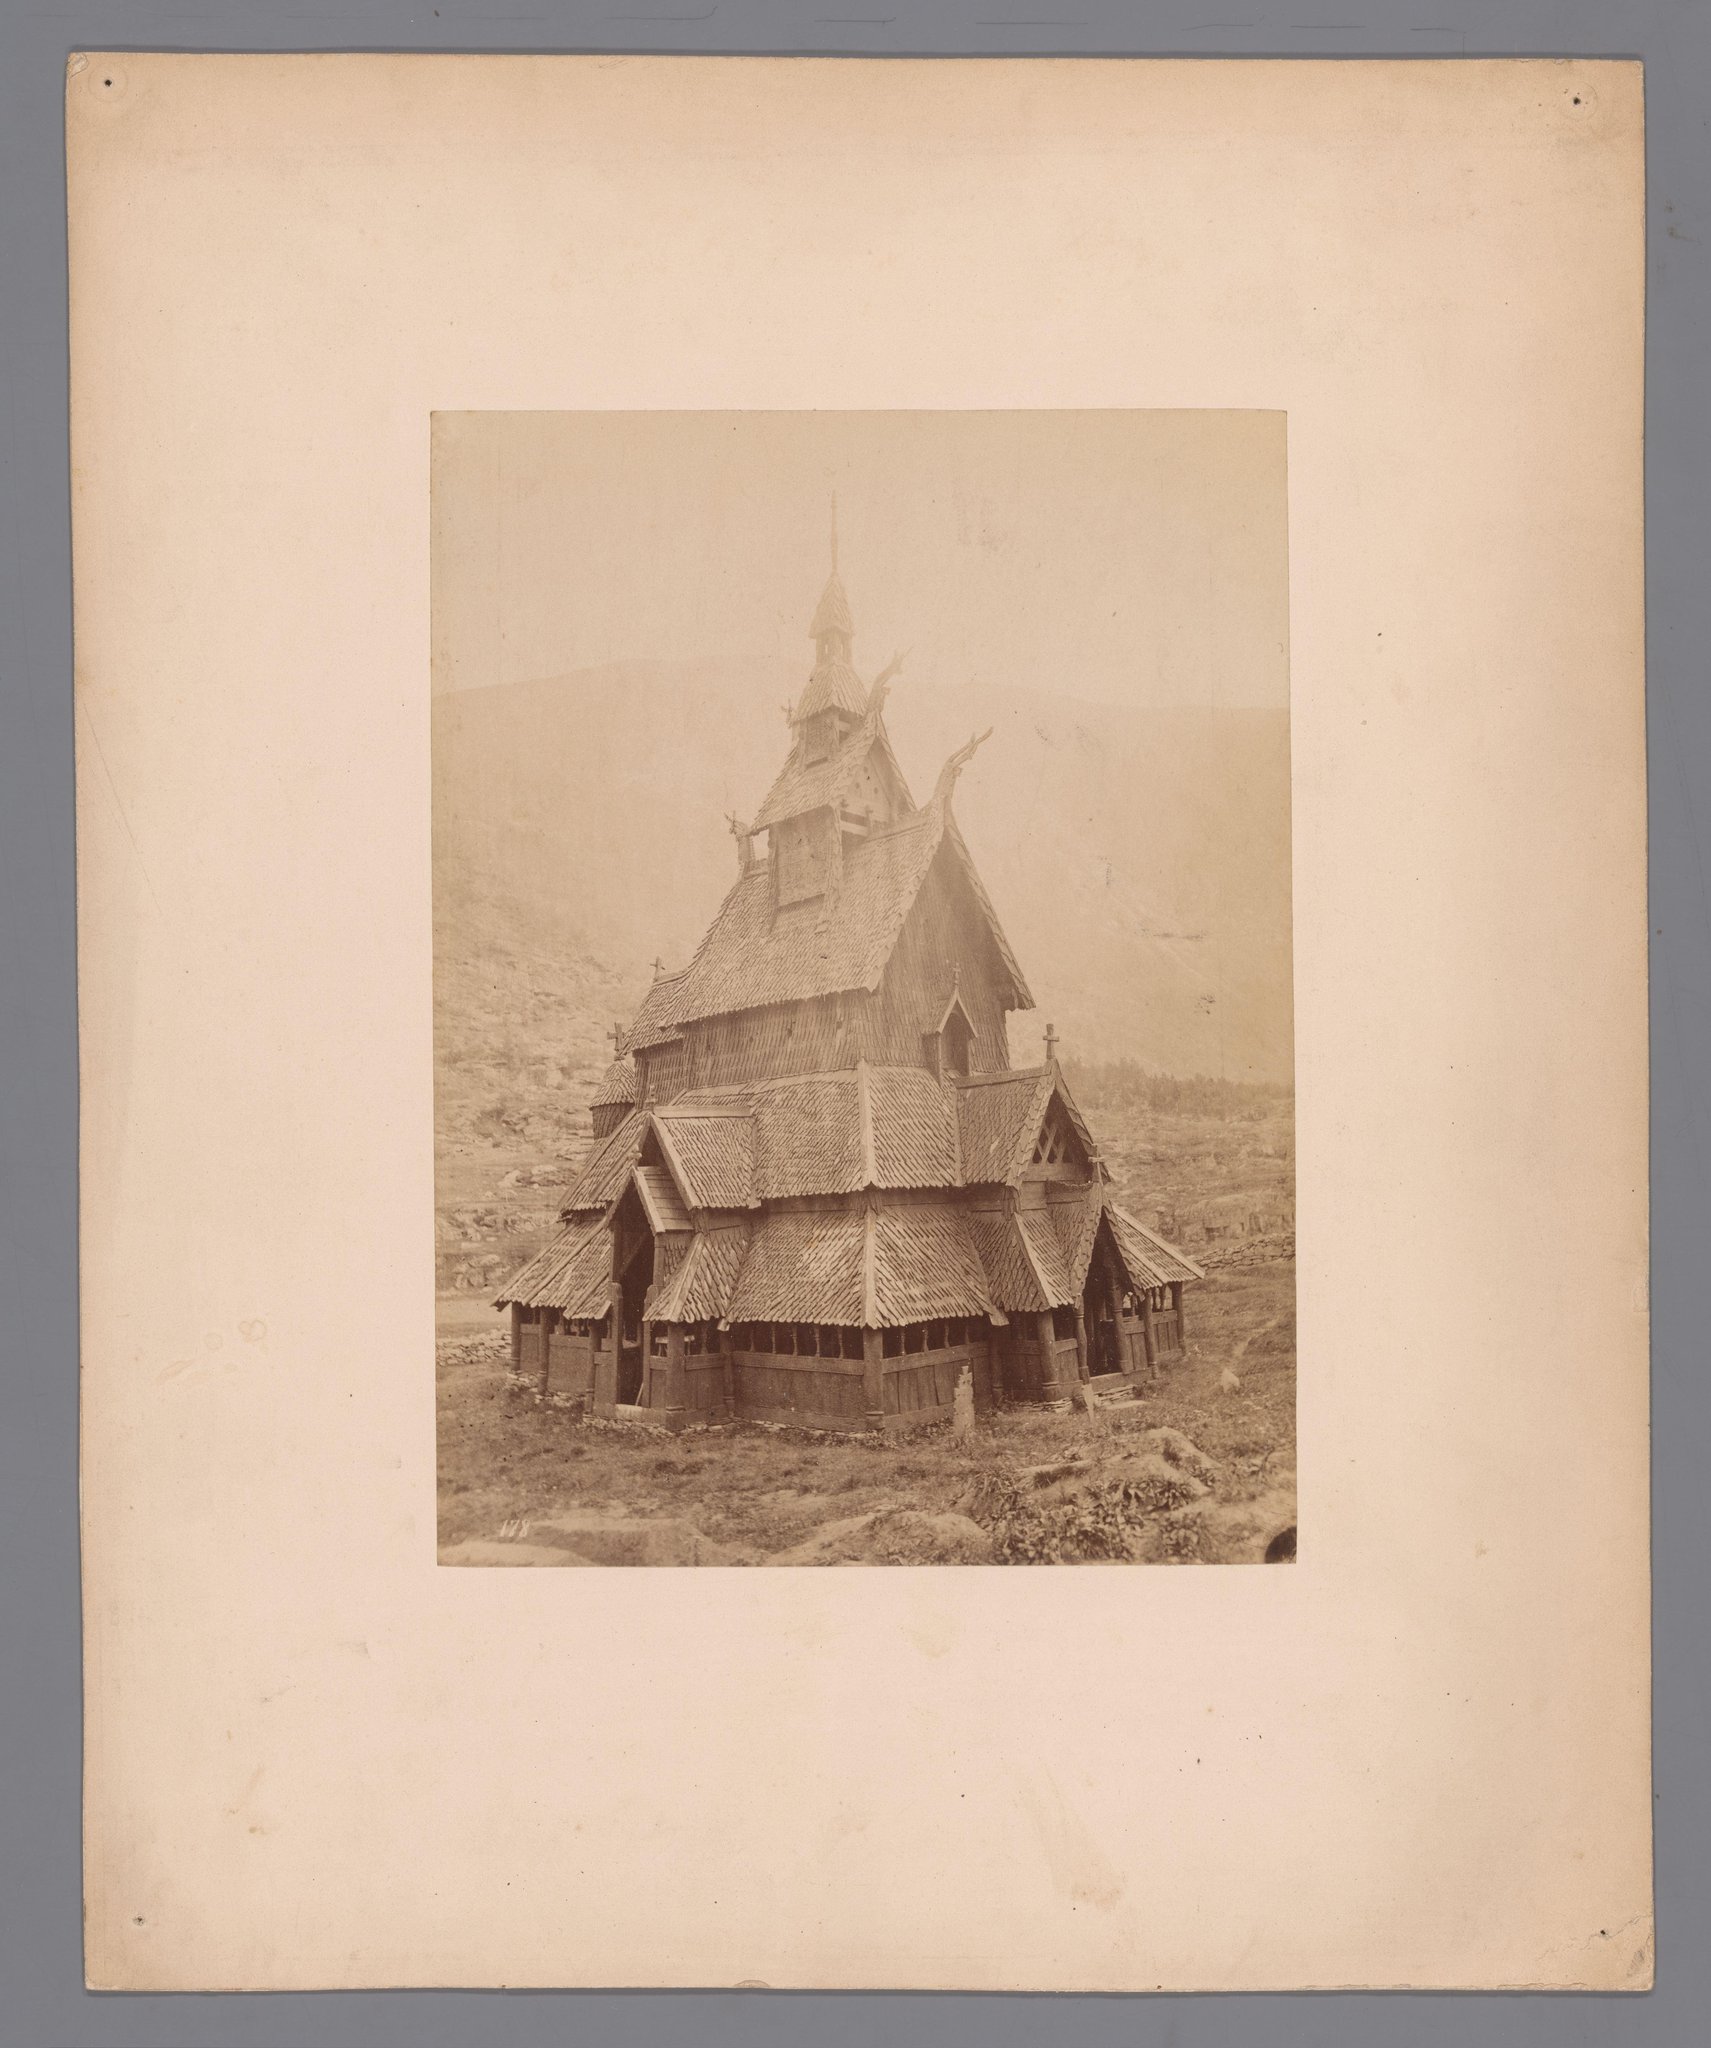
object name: photograph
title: Gezicht op de staafkerk van Borgund in Noorwegen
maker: Anonymous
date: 1860-1900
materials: cardboard, paper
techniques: albumen print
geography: borgund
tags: the christian churches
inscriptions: inscription: ‘Norge/ Borgundskirke i Laerdal, Sogn.’